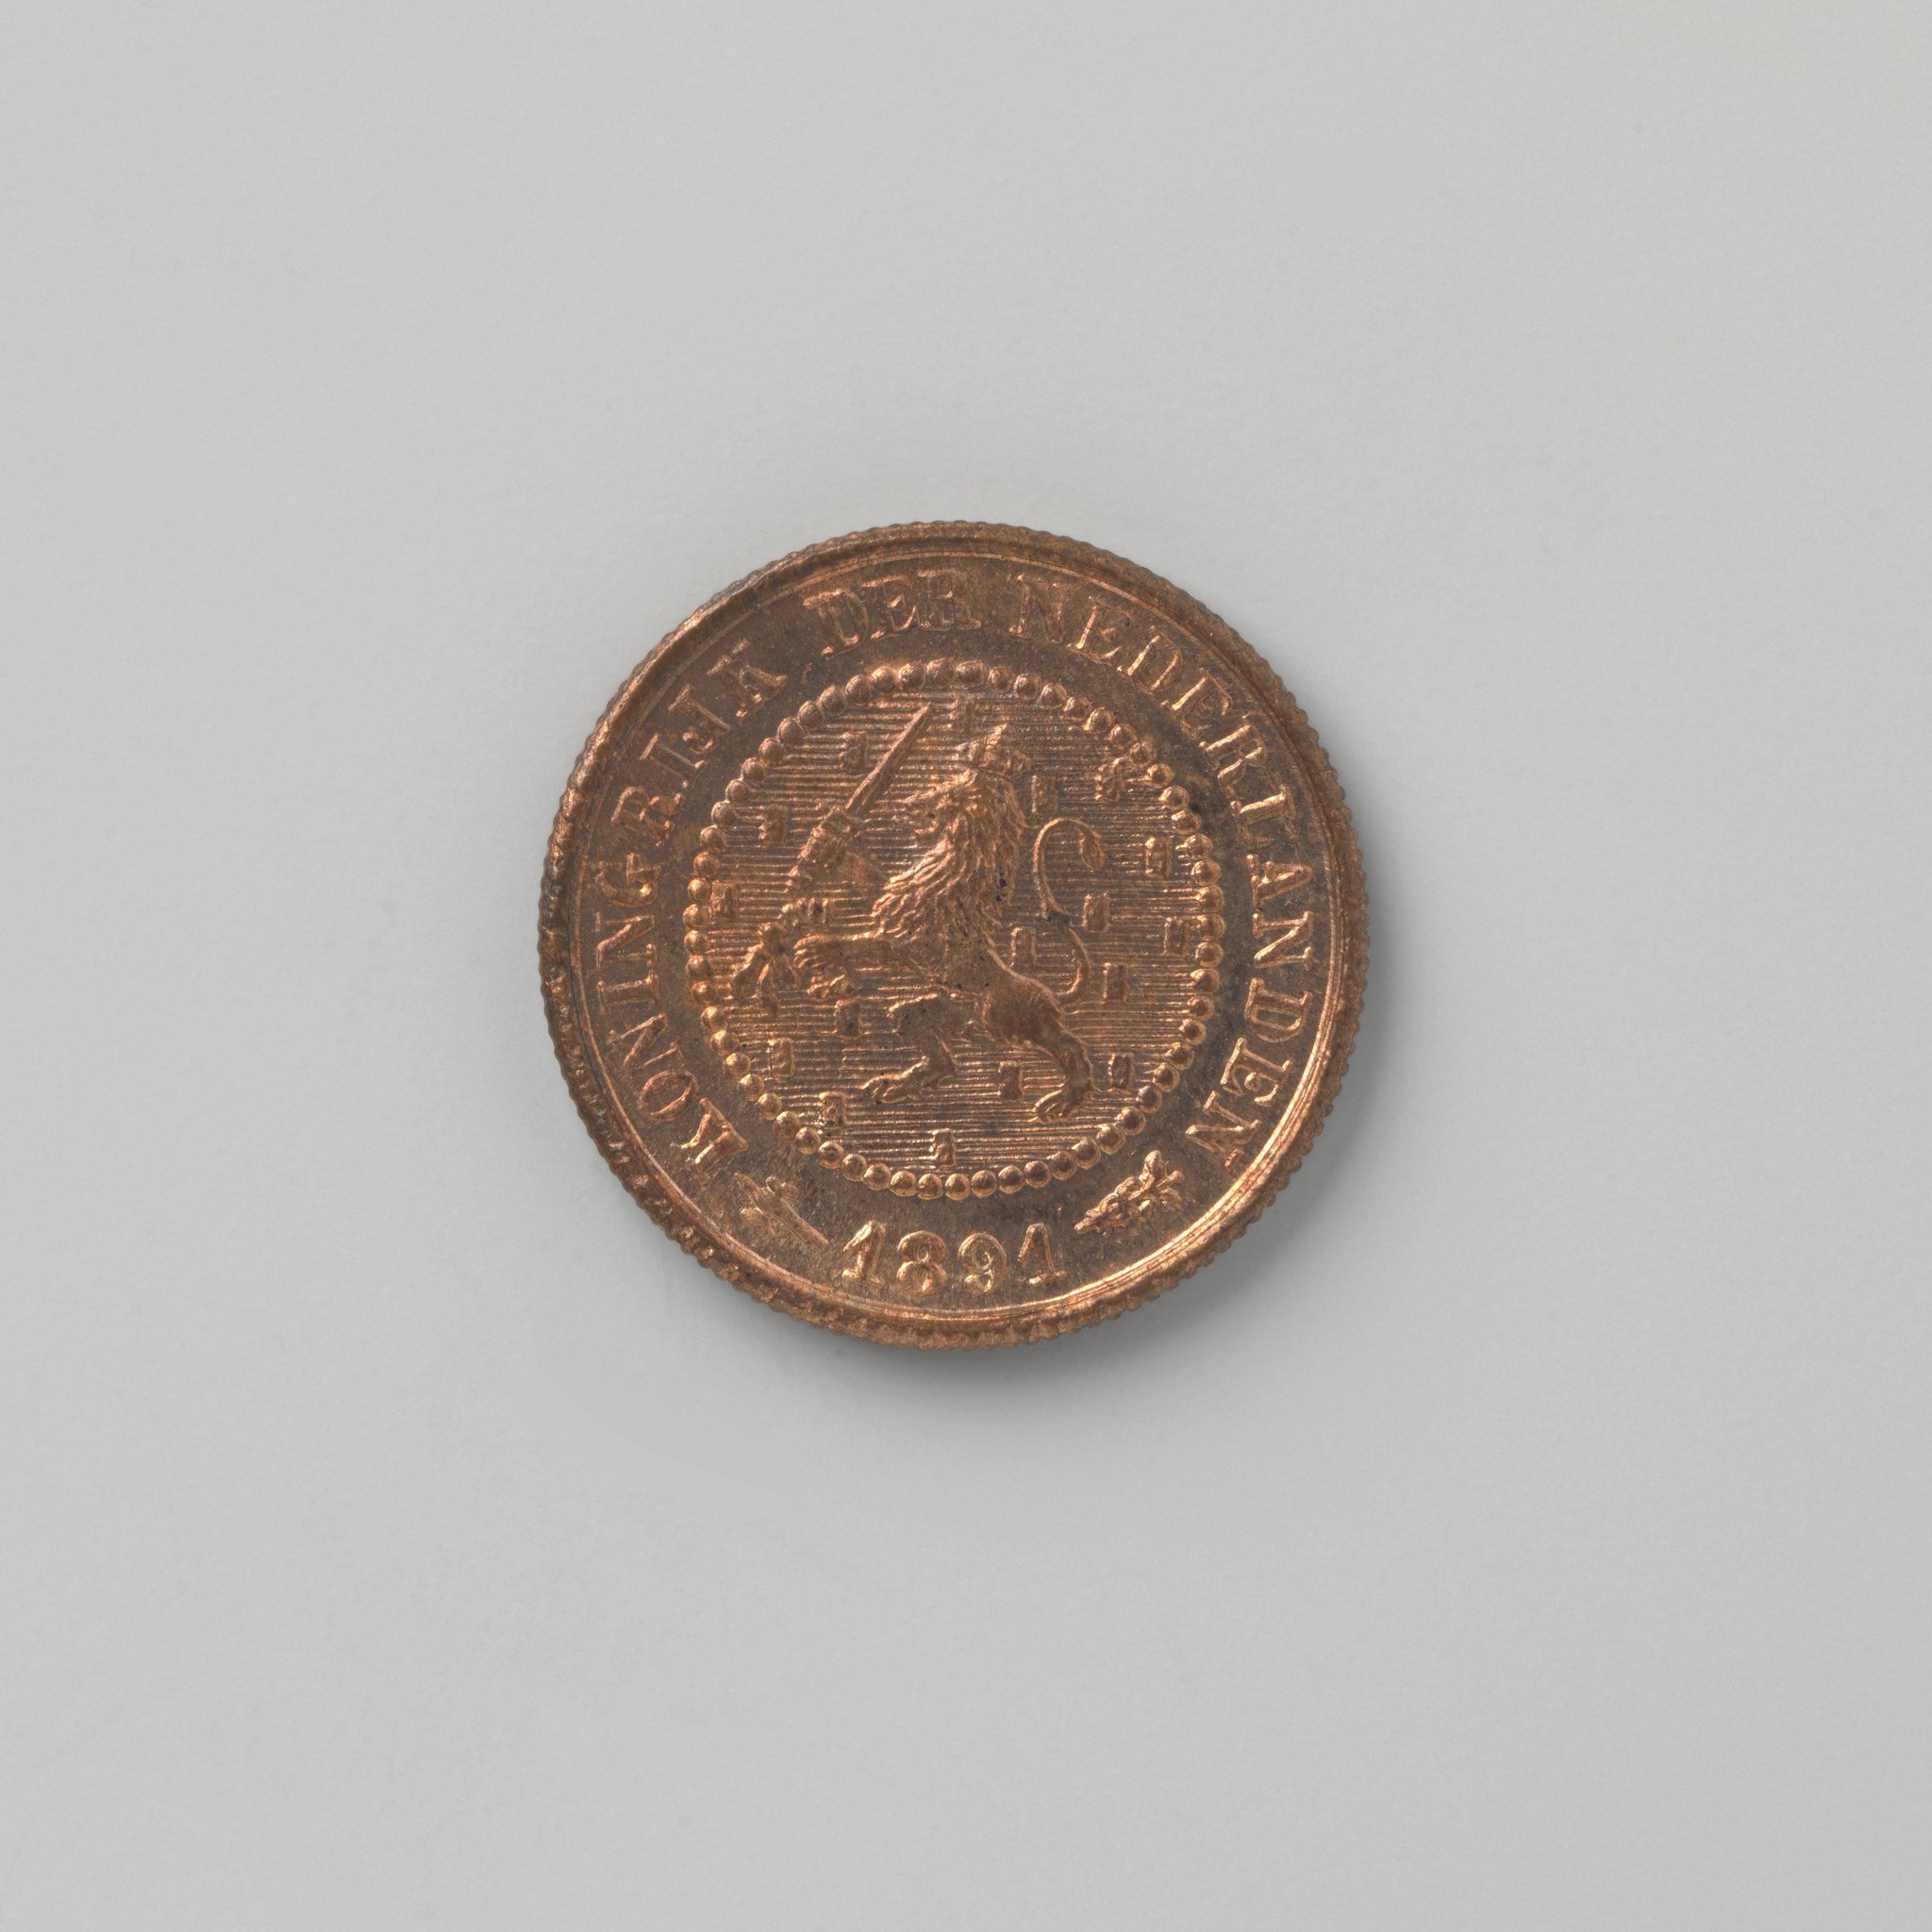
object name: coin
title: Nederlandse ½ cent,1891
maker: wilhelmina of the netherlands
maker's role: print maker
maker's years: 1880-1962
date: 1891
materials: bronze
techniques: striking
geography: utrecht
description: Bronzen munt. Voorzijde: in een veld rijkswapen. Jaartal onderaan in omschrift. Keerzijde: binnen twee samengebonden oranjetakken waarde-aanduiding ½ cent. Kartelrand.